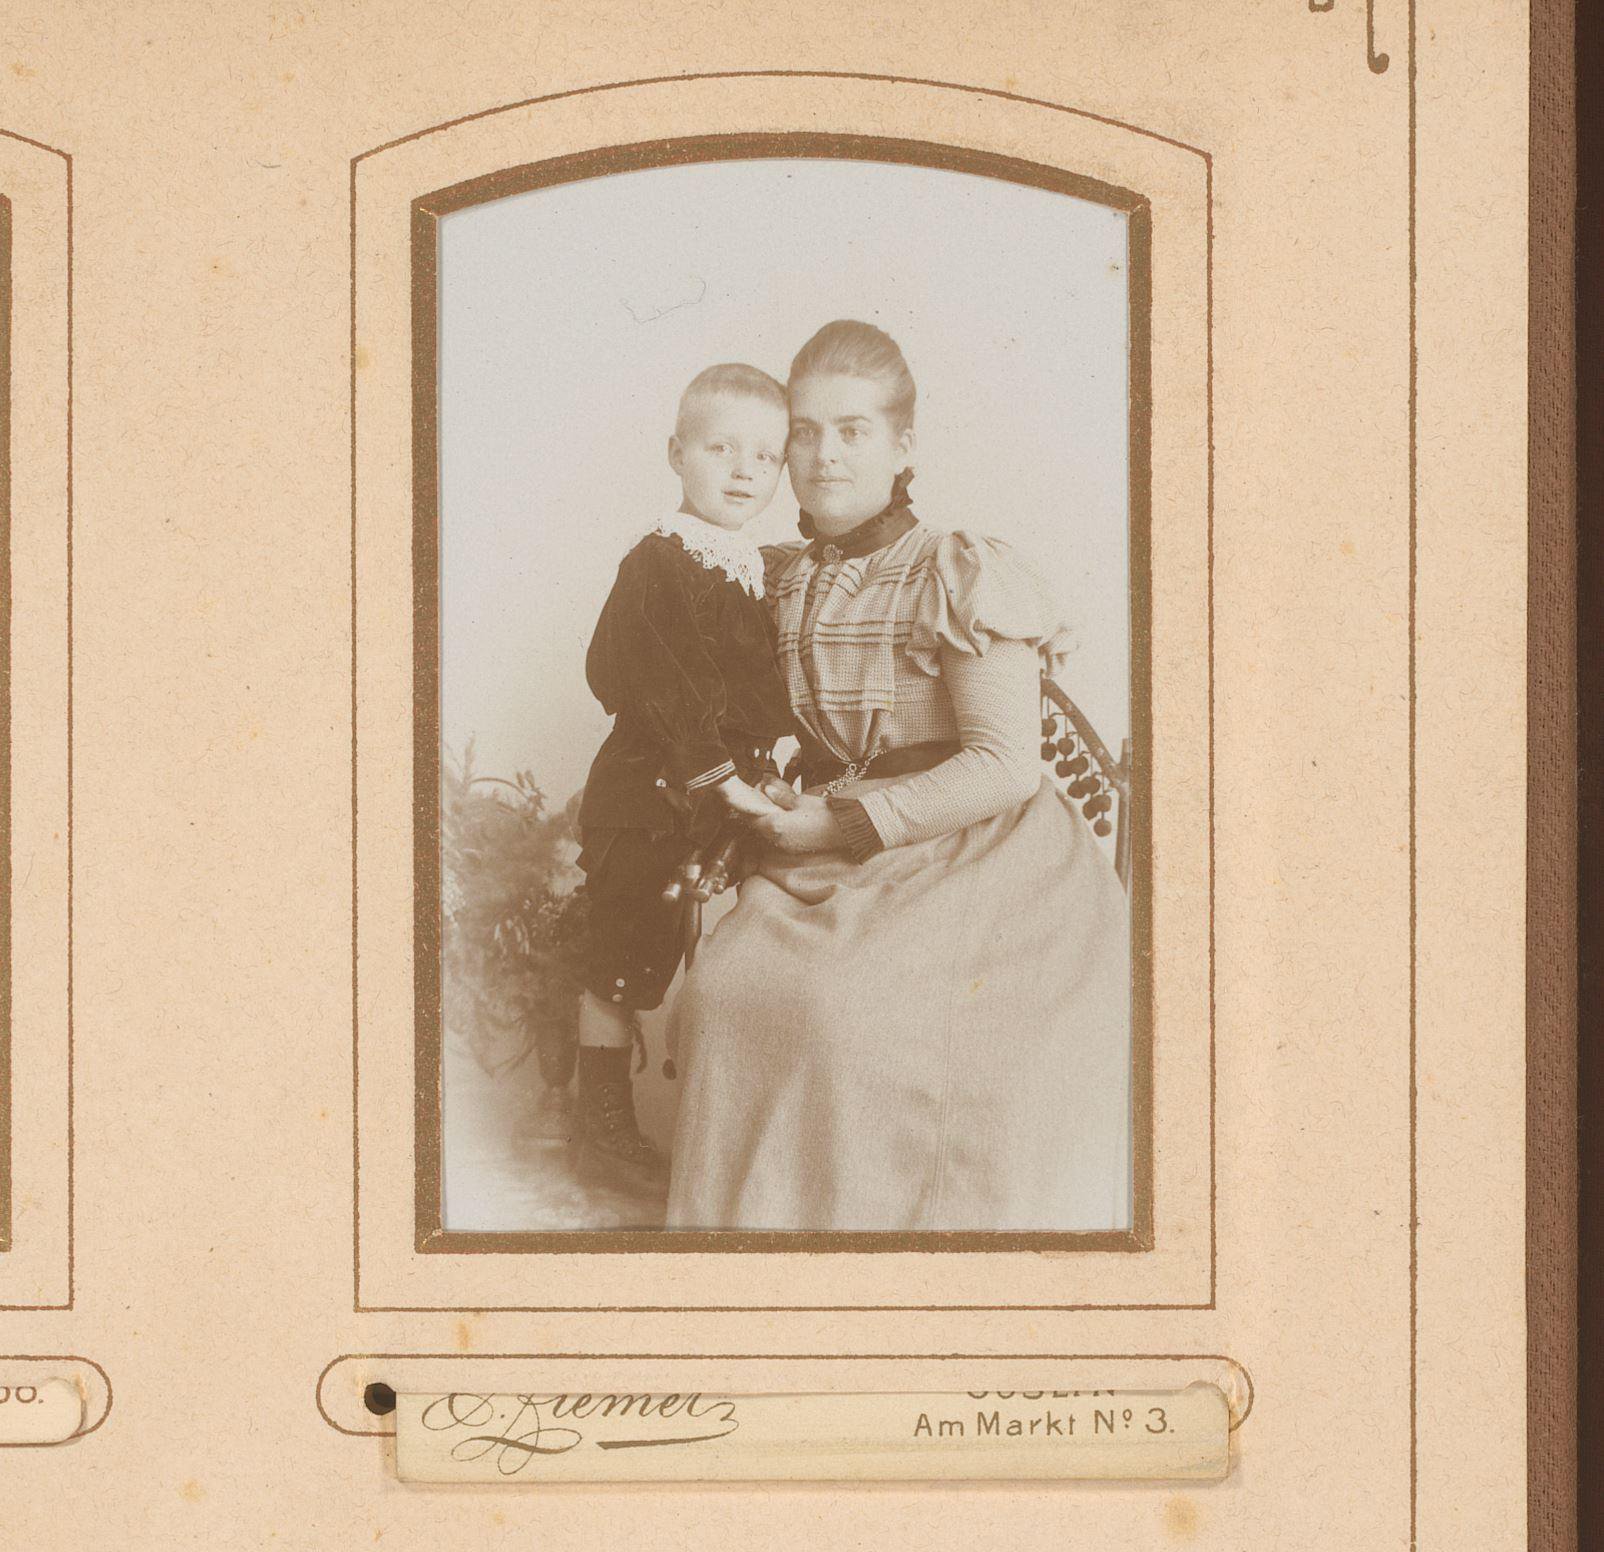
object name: photograph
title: Portret van een moeder met kind, aangeduid als Hedwig en Werner von Holtzendorff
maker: e. ziemer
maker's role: fotograaf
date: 1880-1910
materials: cardboard, photographic support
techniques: collodion silver print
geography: koszalin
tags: historical persons - bb - woman, boy (child between toddler and youth), mother and child(ren), woman and child(ren) (family group)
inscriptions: annotation: ‘[...] Nelly/ Hedwig von Holtzendorff/ mit [...] Werner’, inscription: ‘E. Ziemer/ Photograph/ Cöslin/ Am Markt 3/ neben dem Rathhause’